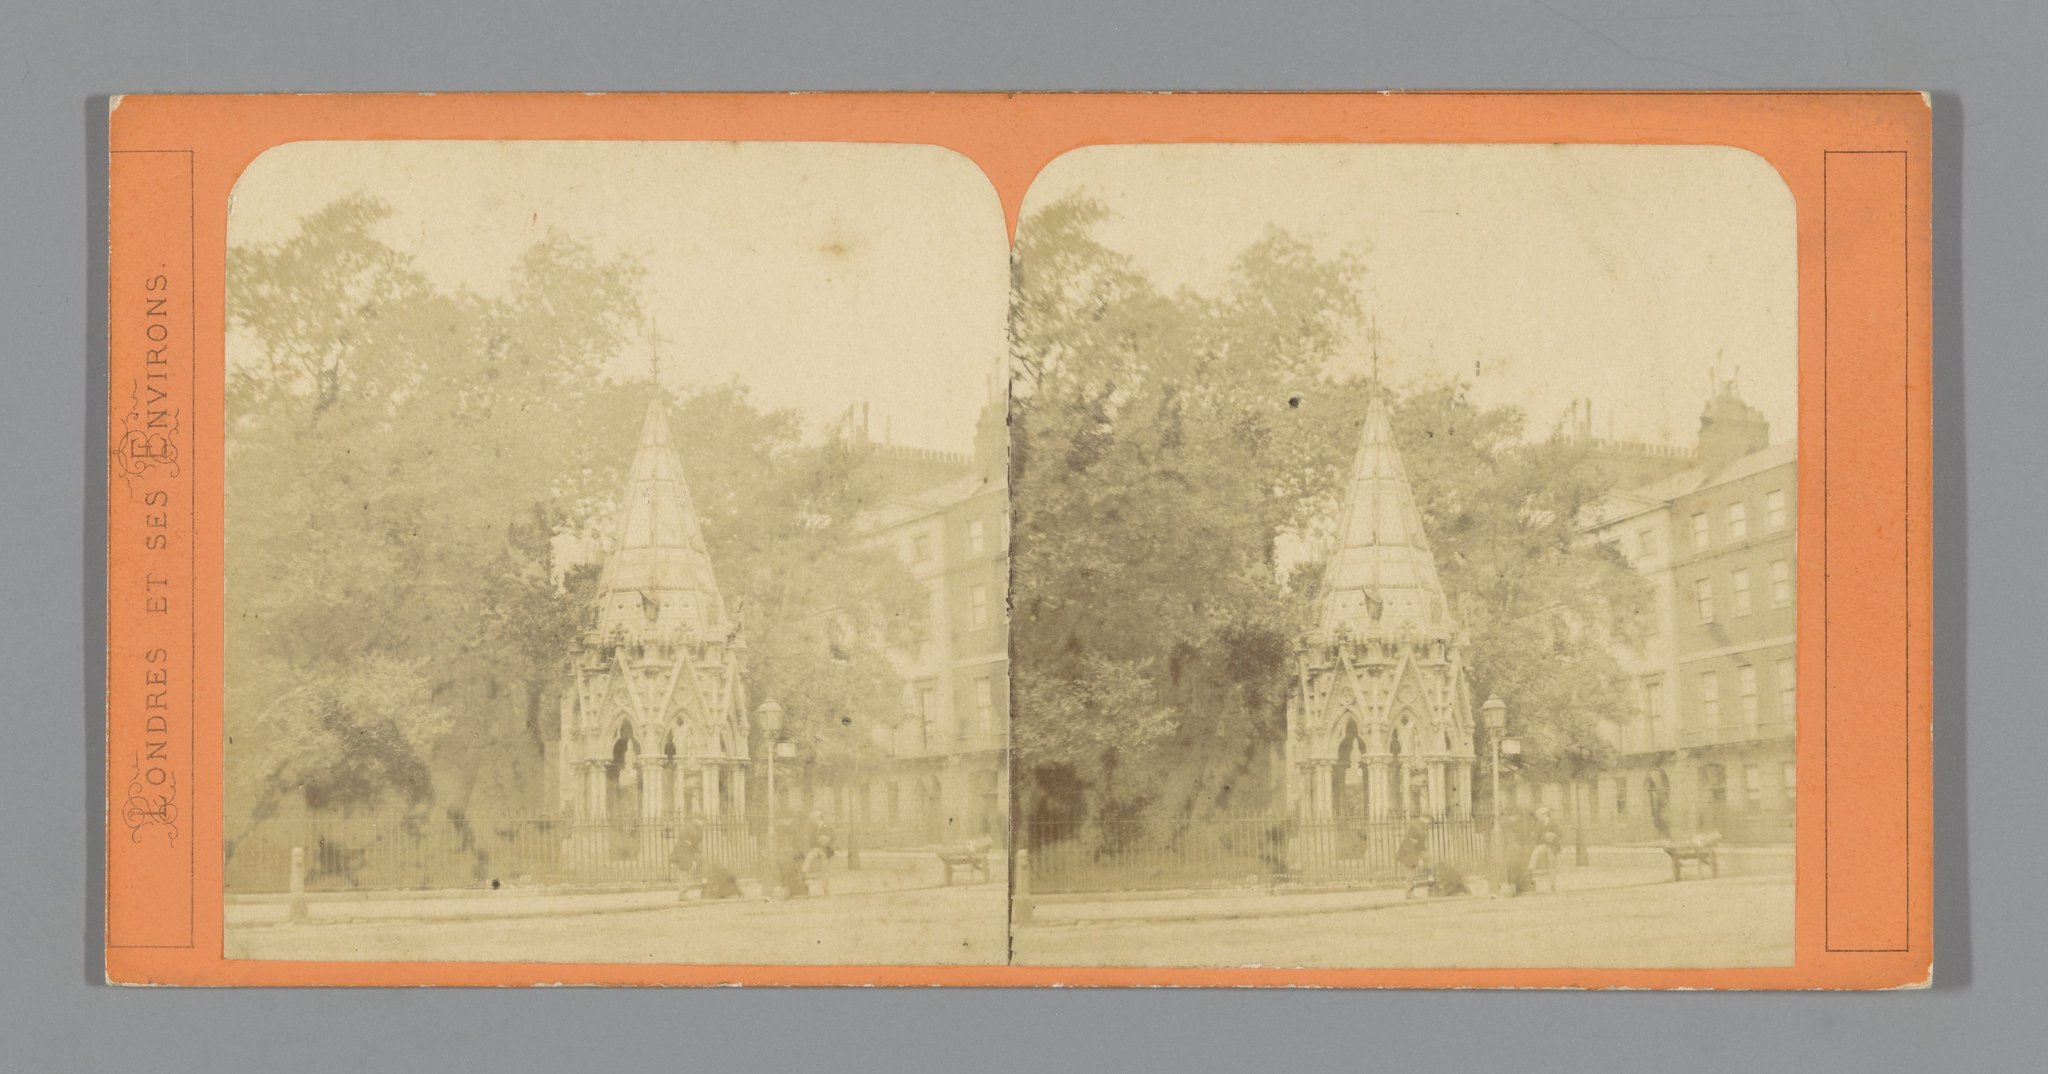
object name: stereograph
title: Londres et ses Environs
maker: Anonymous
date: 1850-1880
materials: cardboard, photographic support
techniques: albumen print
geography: london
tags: ornamental fountain, london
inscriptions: inscription: ‘Fontaine du Parlement’